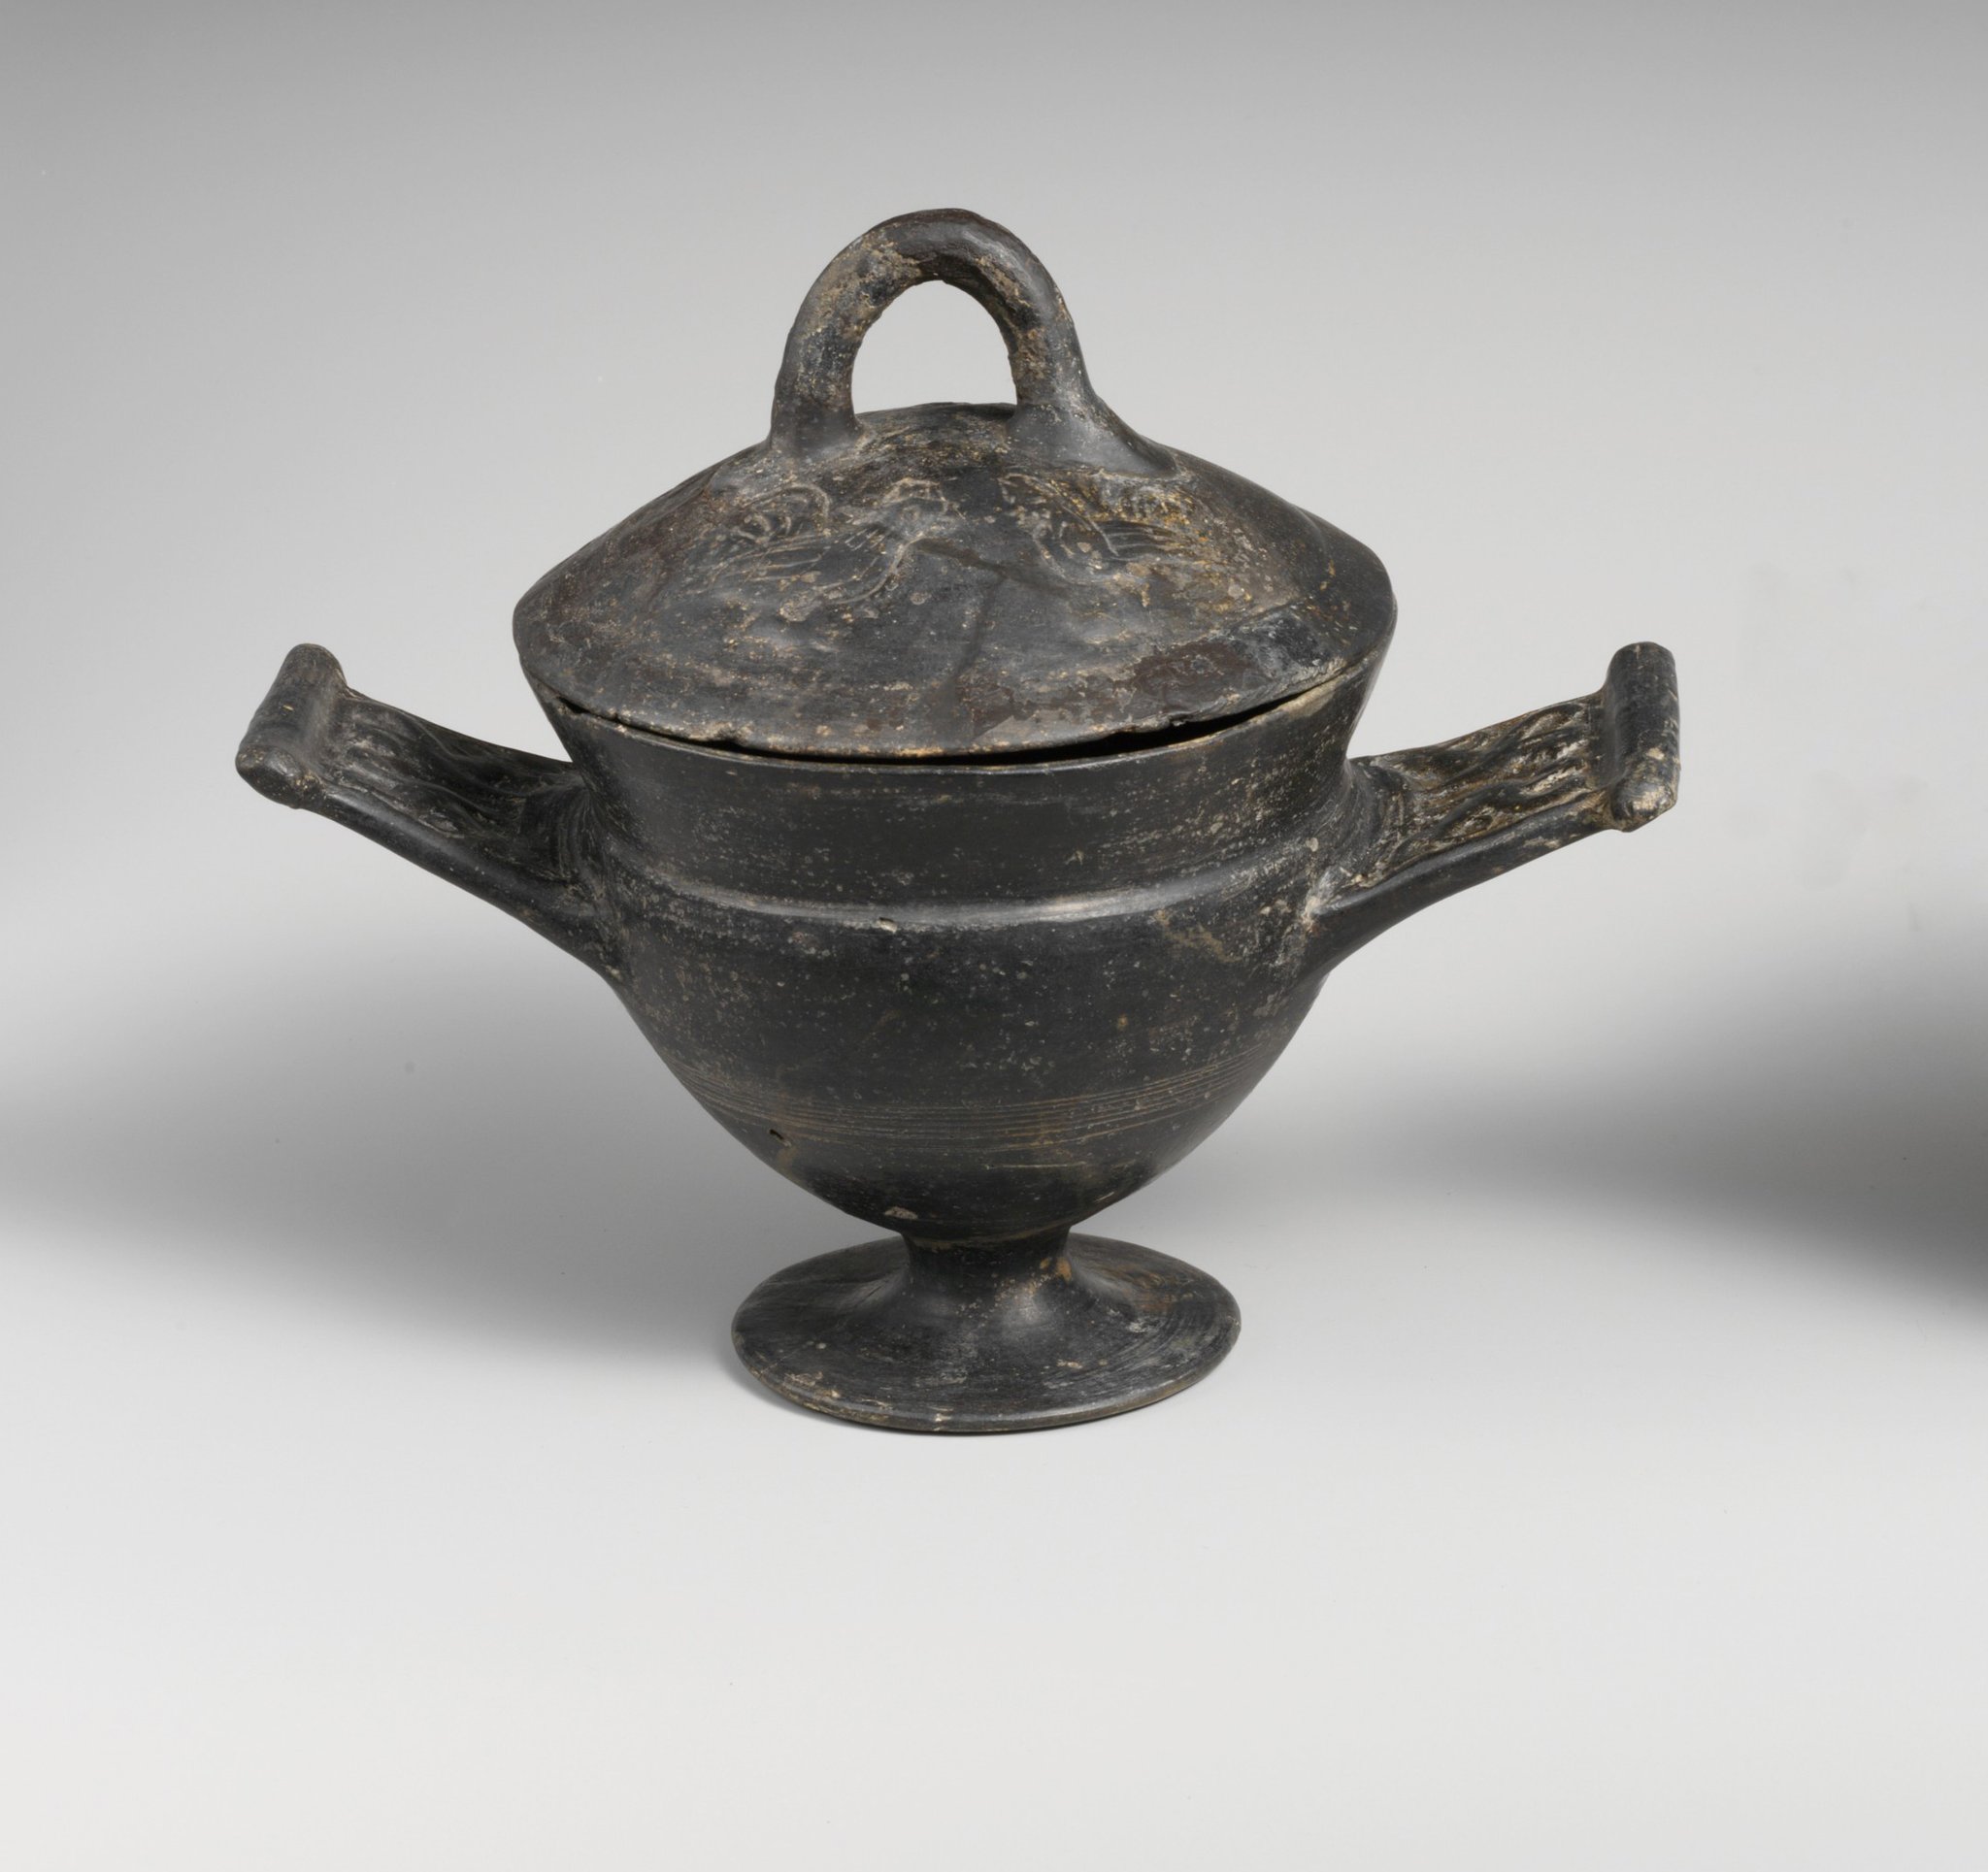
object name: cup with lid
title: Terracotta cup with lid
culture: etruscan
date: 650 BCE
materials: terracotta